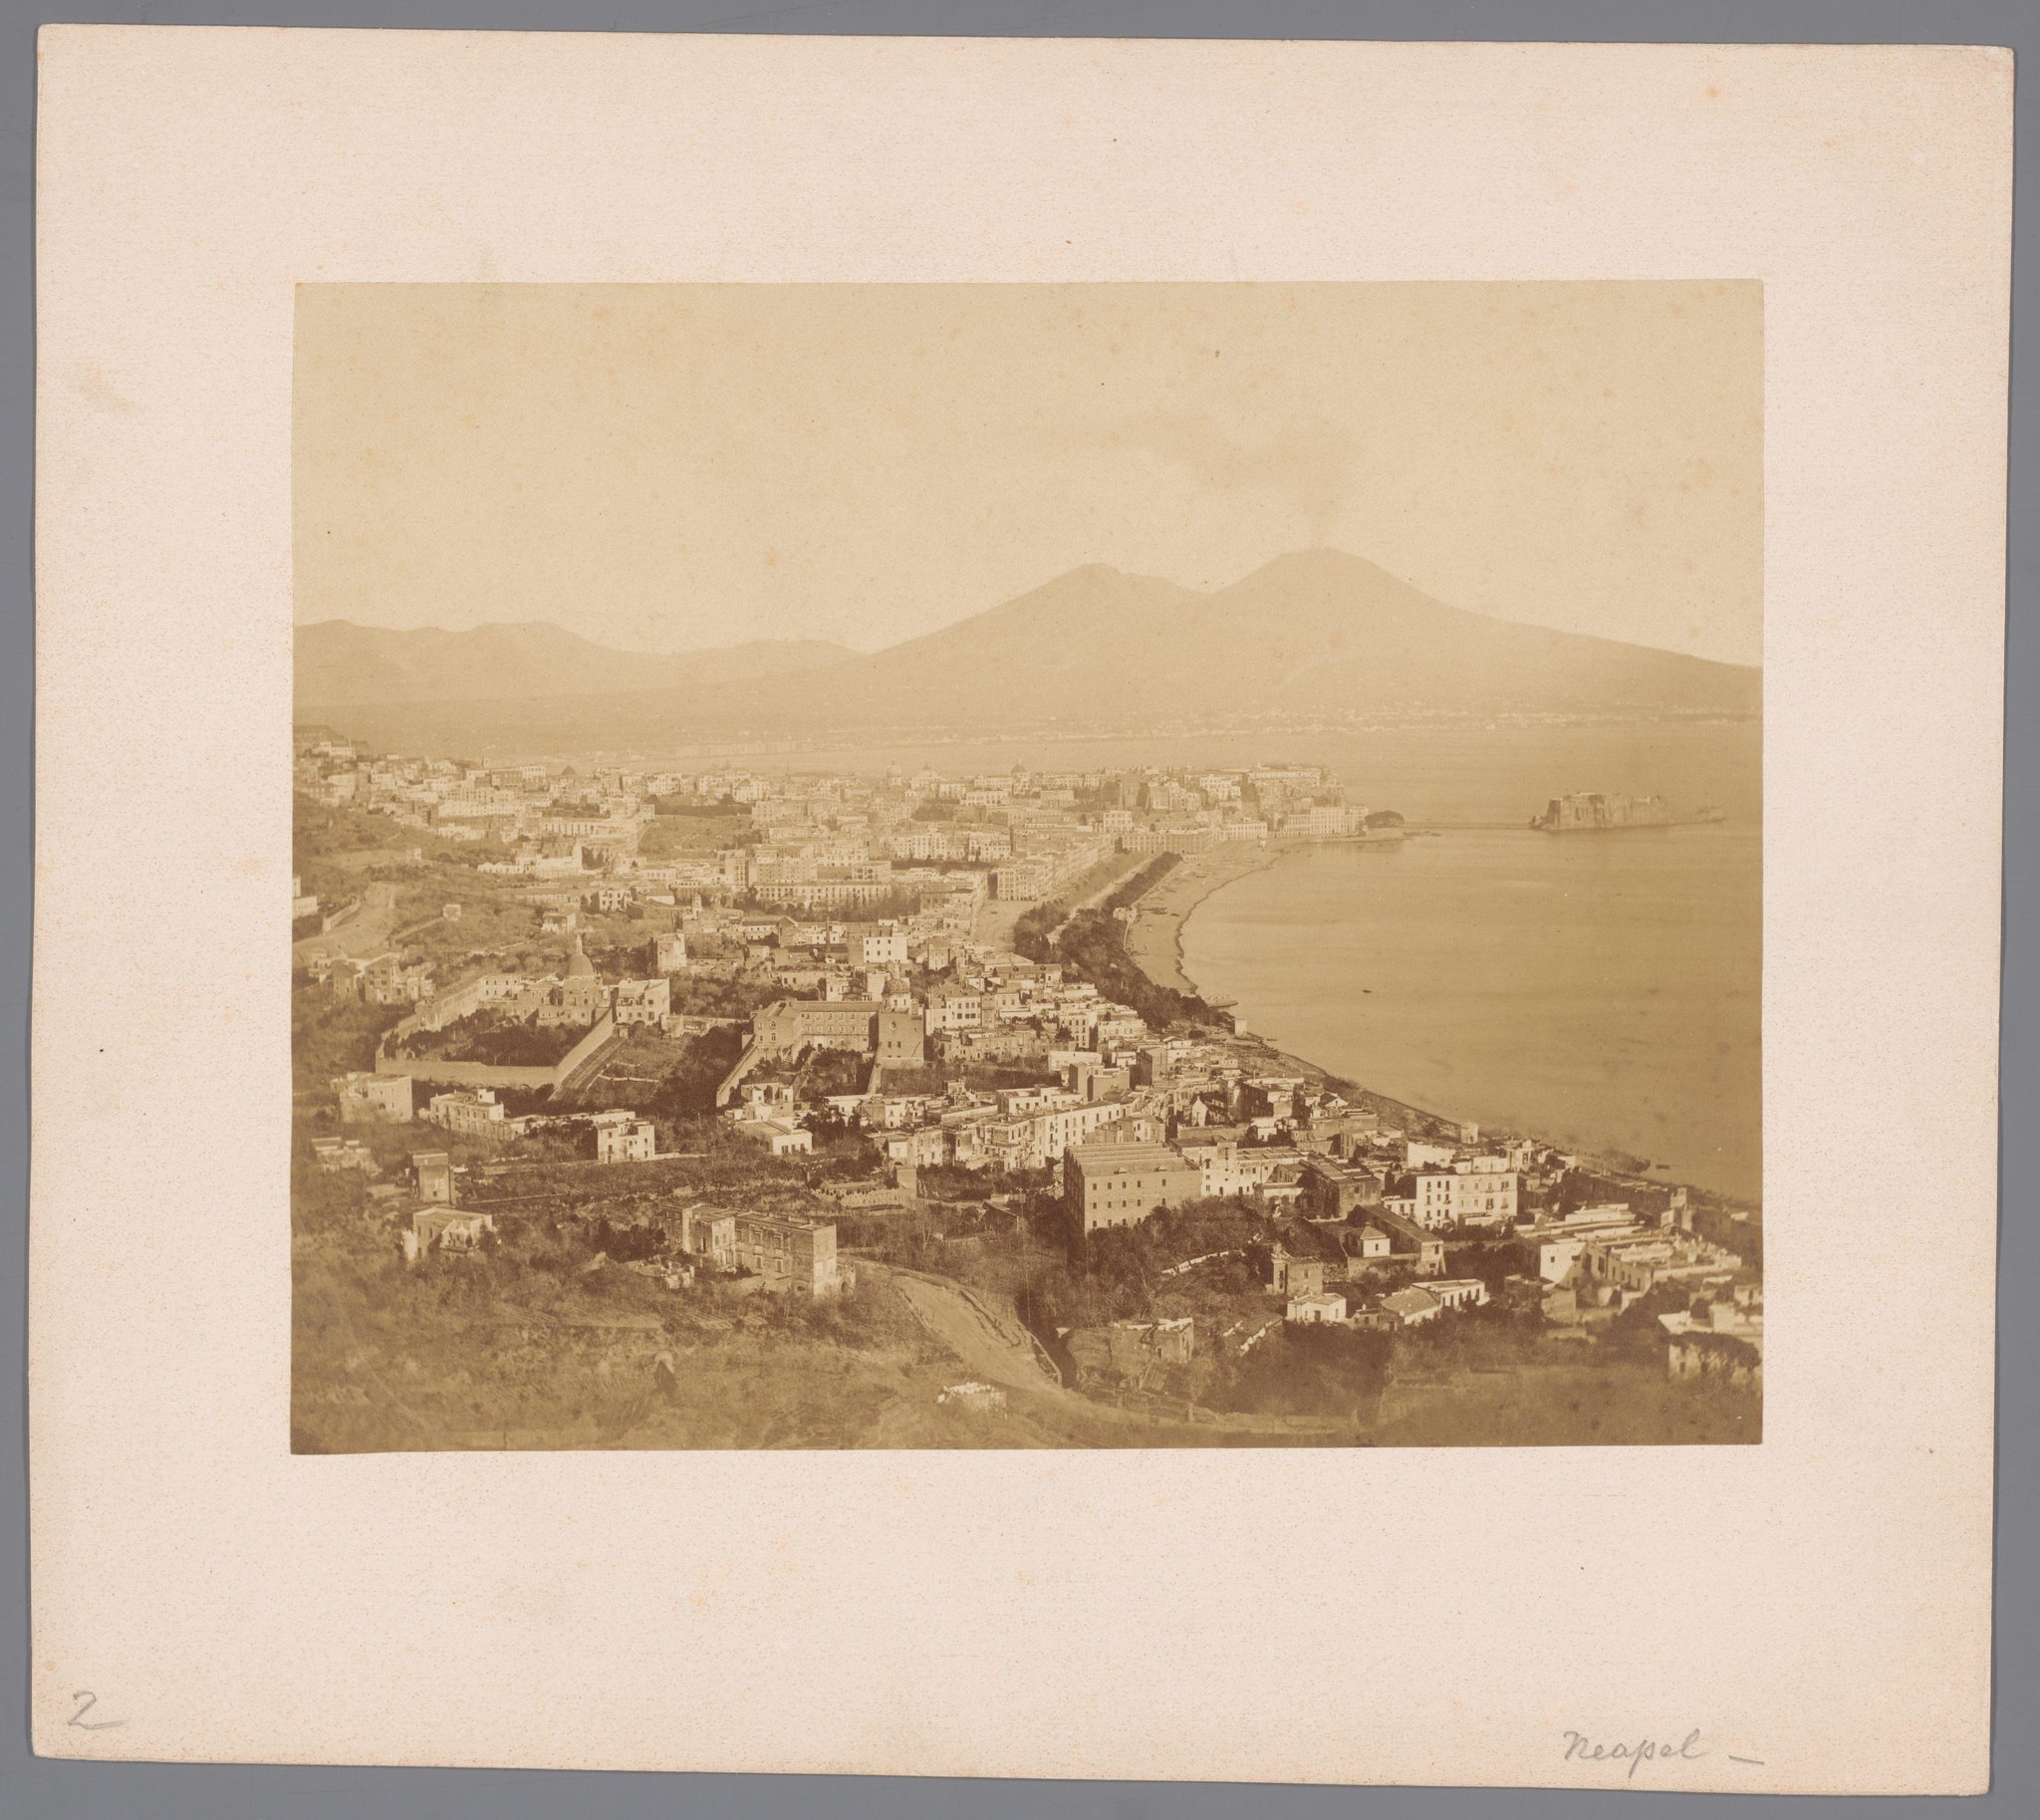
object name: photograph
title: Naepel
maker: giorgio sommer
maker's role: fotograaf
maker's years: 1834-1914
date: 1857-1914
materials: cardboard, paper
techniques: albumen print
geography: naples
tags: gulf, bay, prospect of city, town panorama, silhouette of city, naples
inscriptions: inscription: ‘10’, inscription: ‘'17 - 284’, stamp: ‘R: MVS.’, number: ‘2’